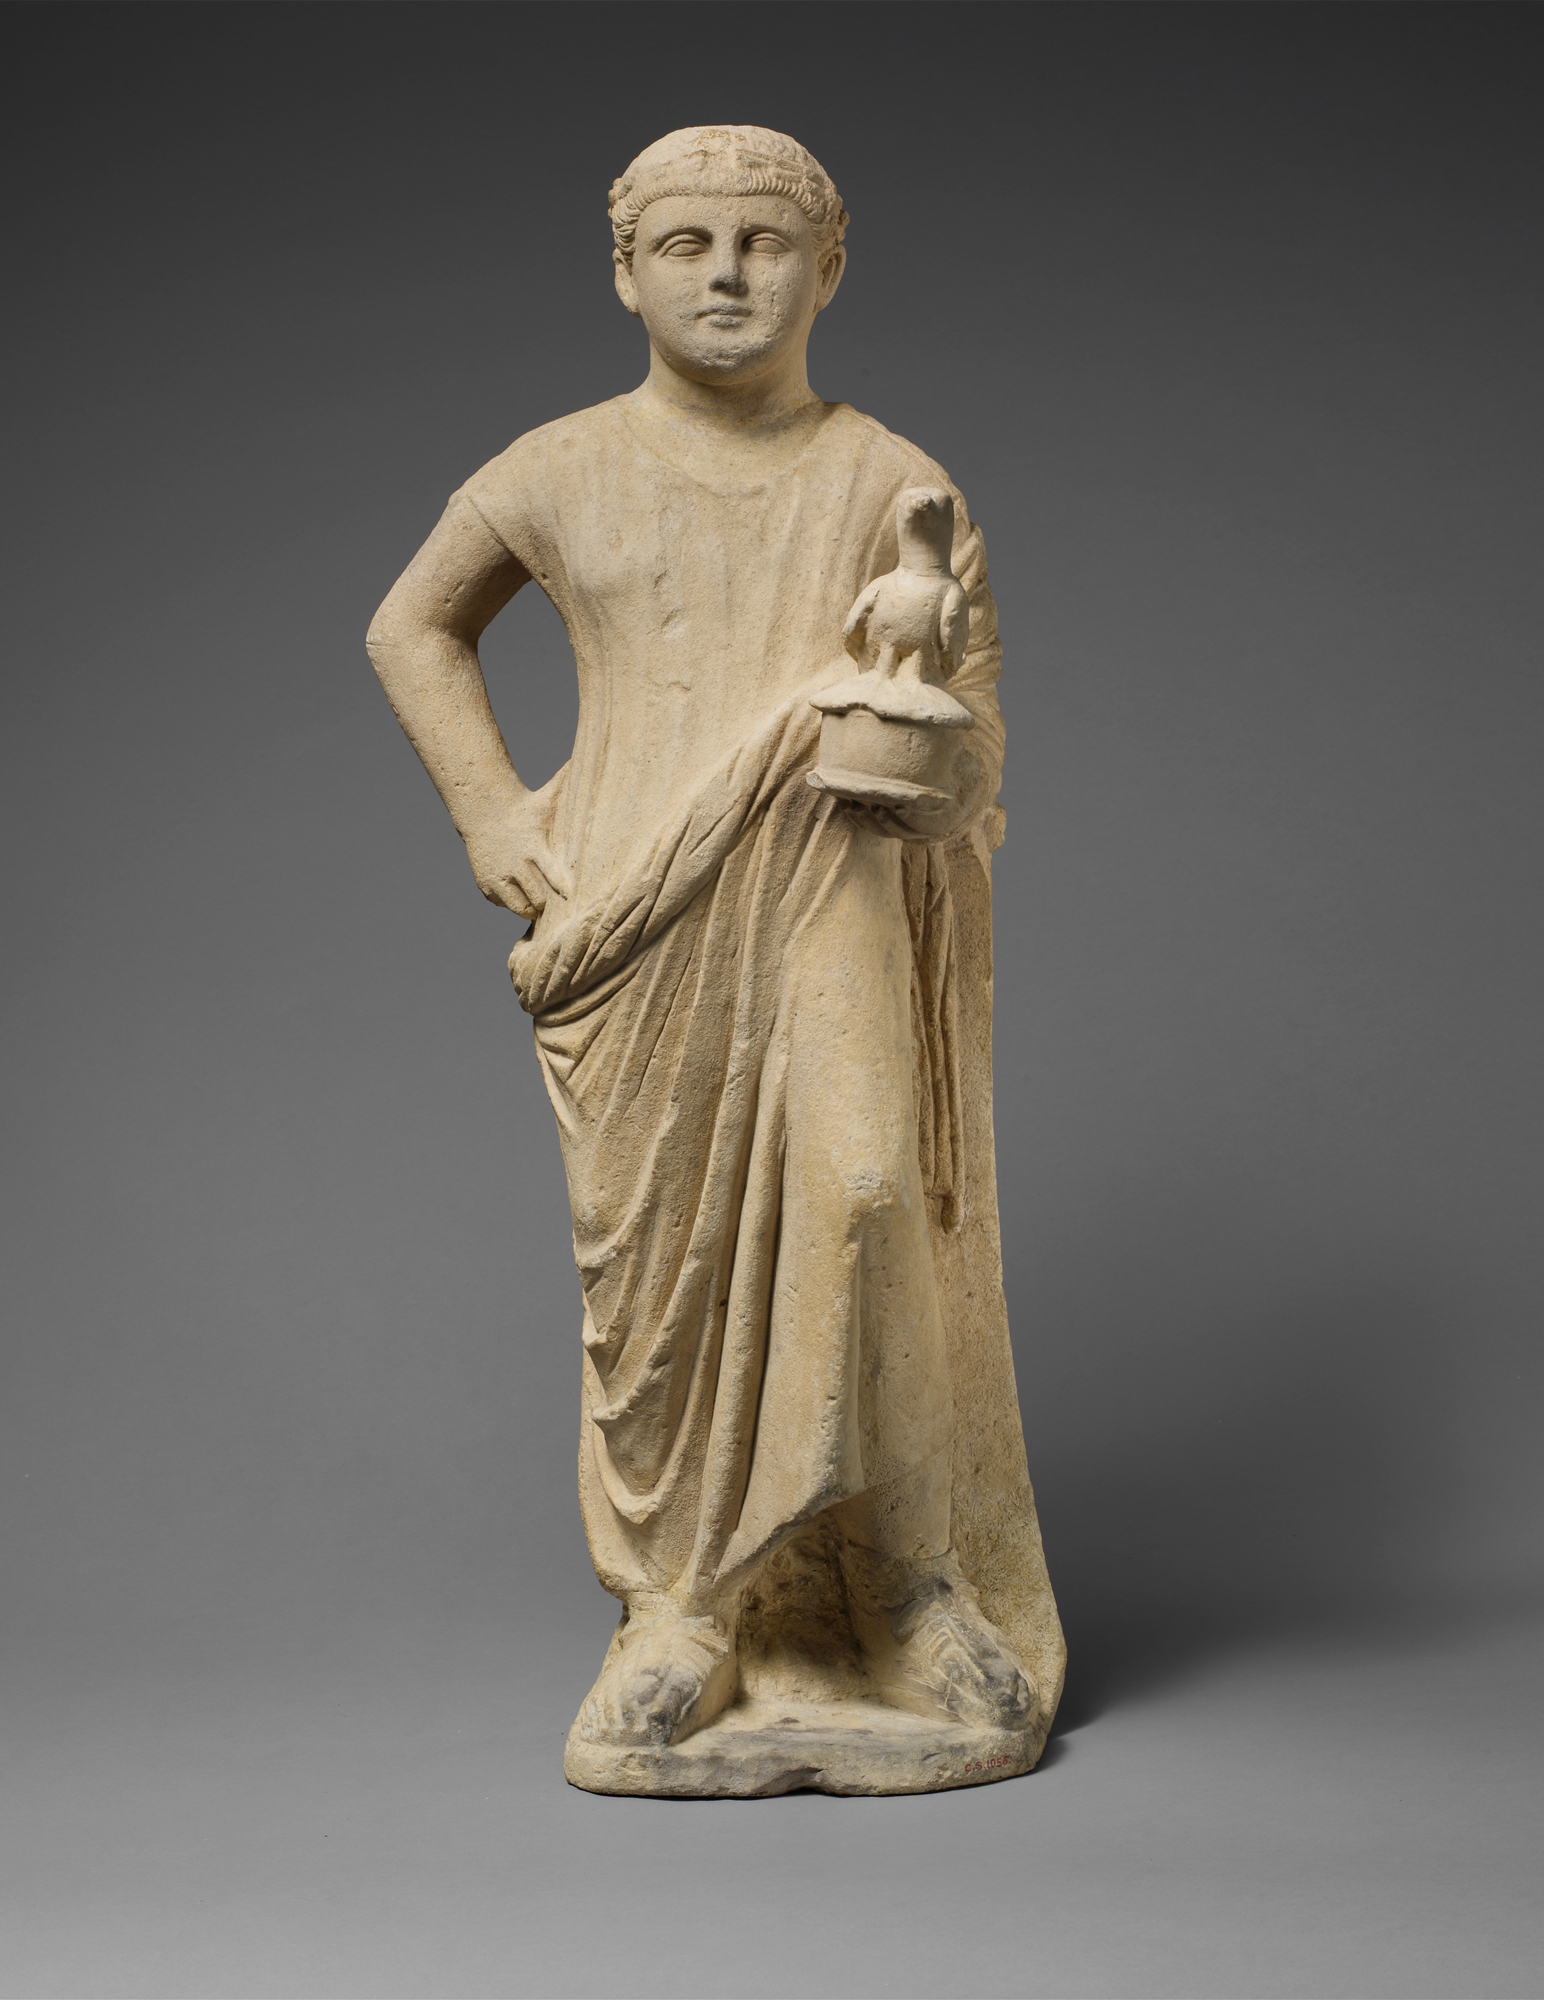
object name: statue of a votary, male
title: Limestone statuette of a boy as a votary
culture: cypriot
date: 300-1 BCE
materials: limestone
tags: doves,boys